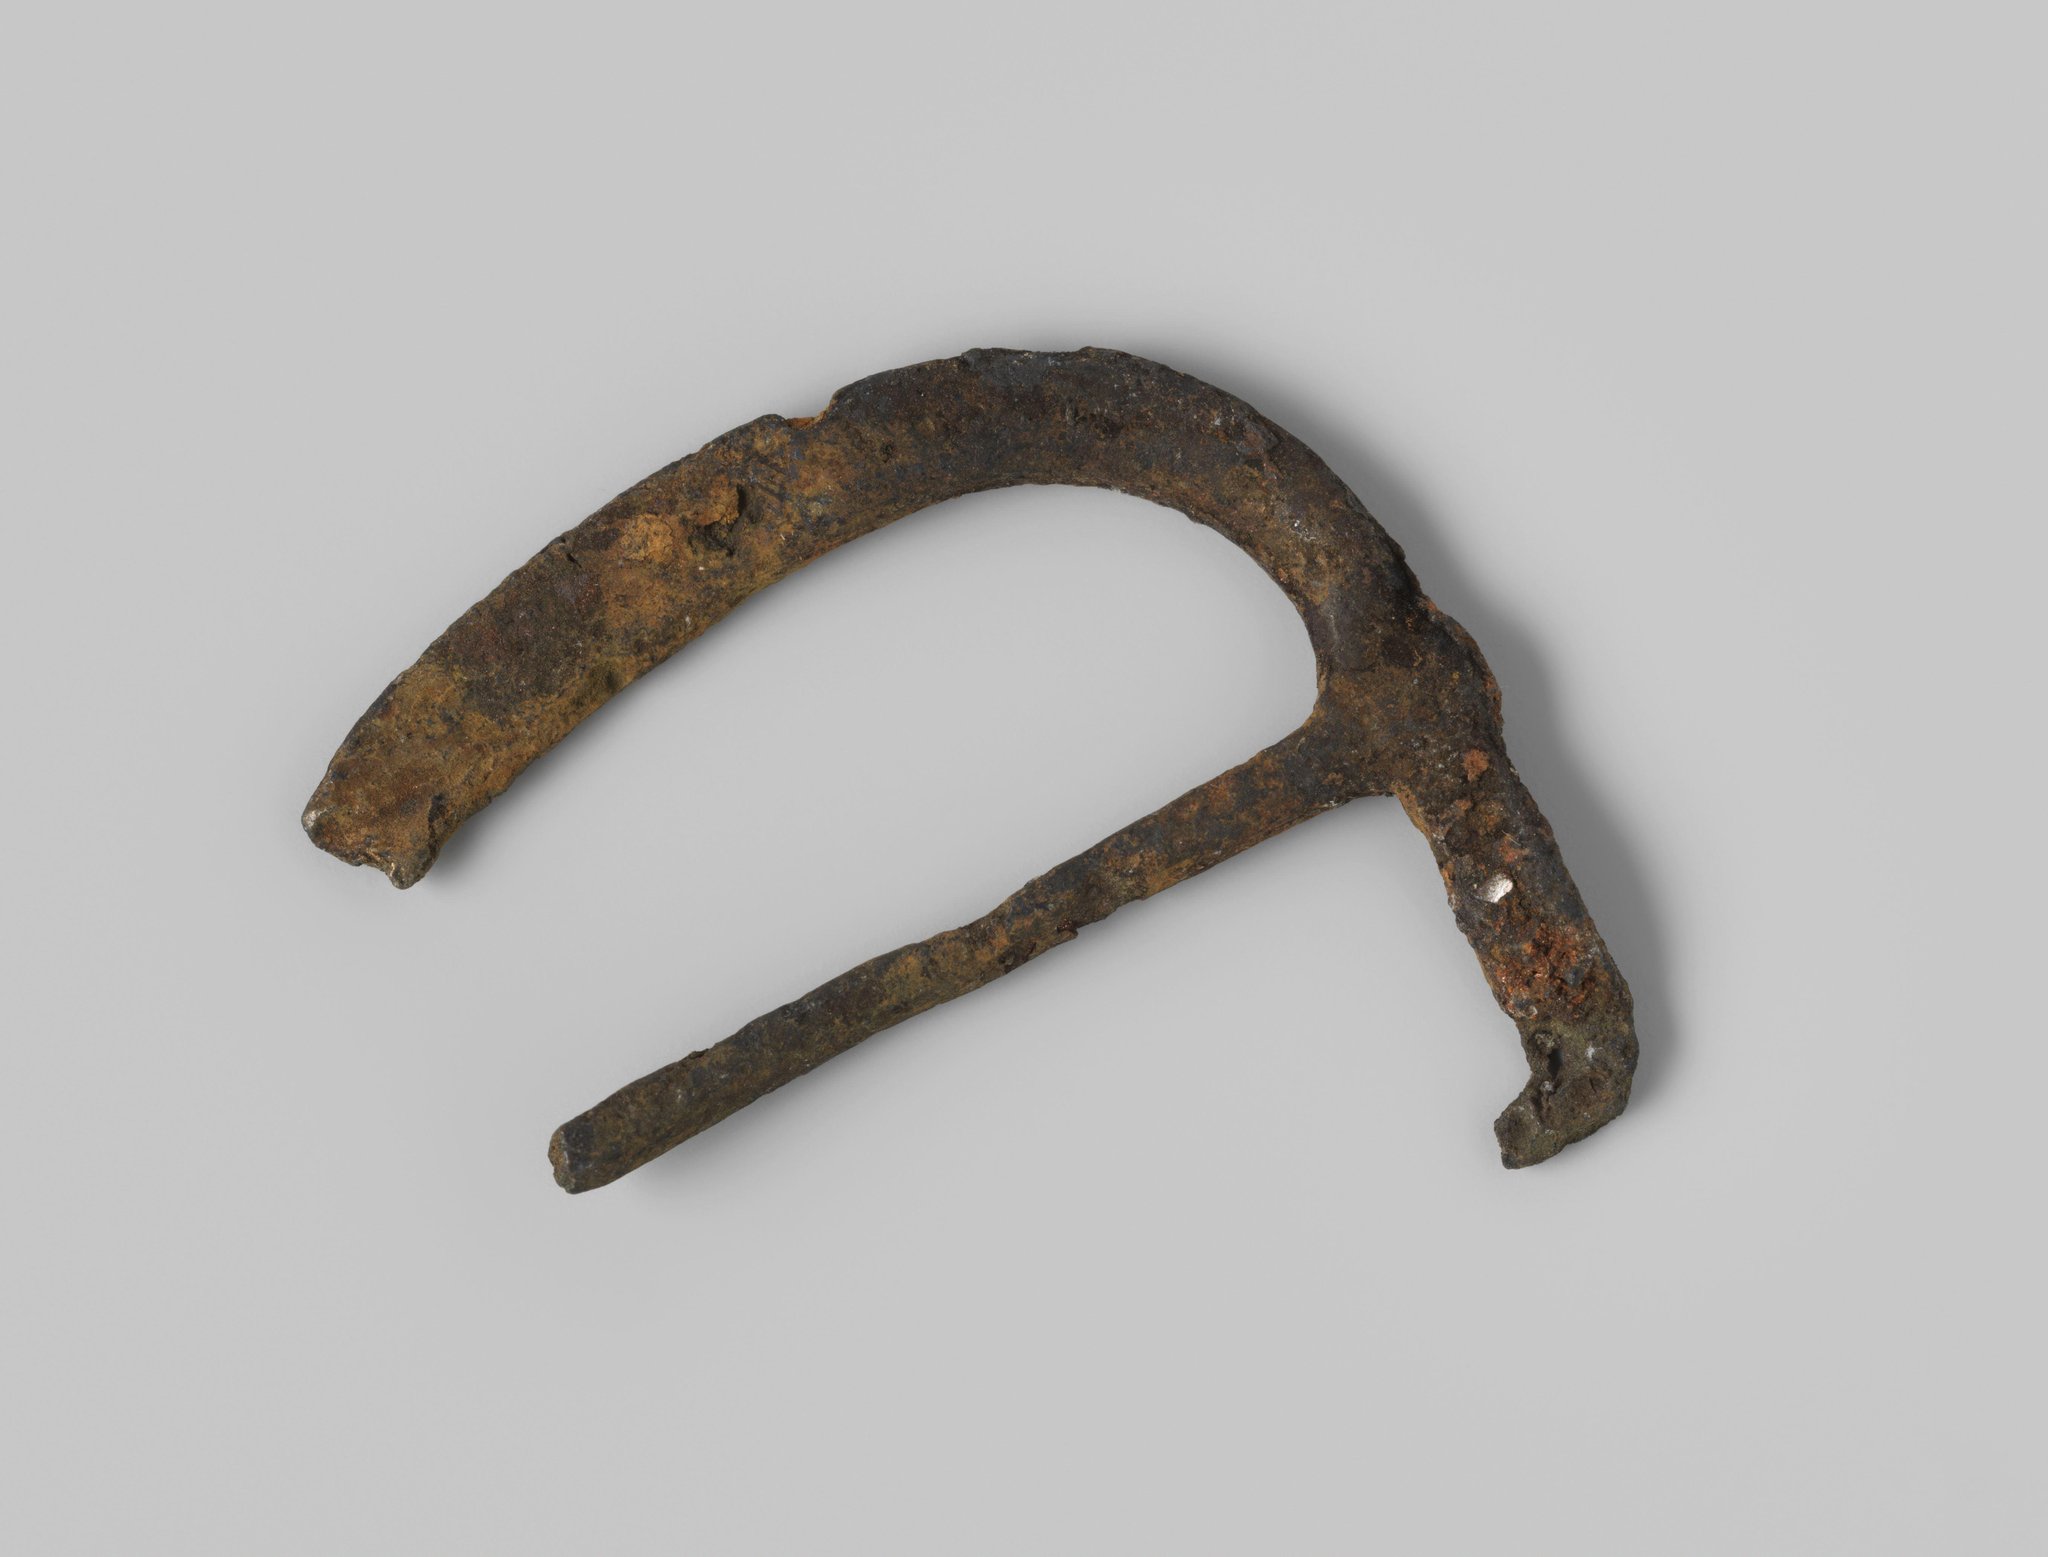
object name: belt buckle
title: Fragment riemgesp uit het wrak van de Oost-Indiëvaarder Hollandia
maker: Anonymous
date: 1700-1743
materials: copper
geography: netherlands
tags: verenigde oostindische compagnie, hollandia (schip), annet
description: D-shaped, fragm of ring, id. NG 1979-182H2177, belt buckle.